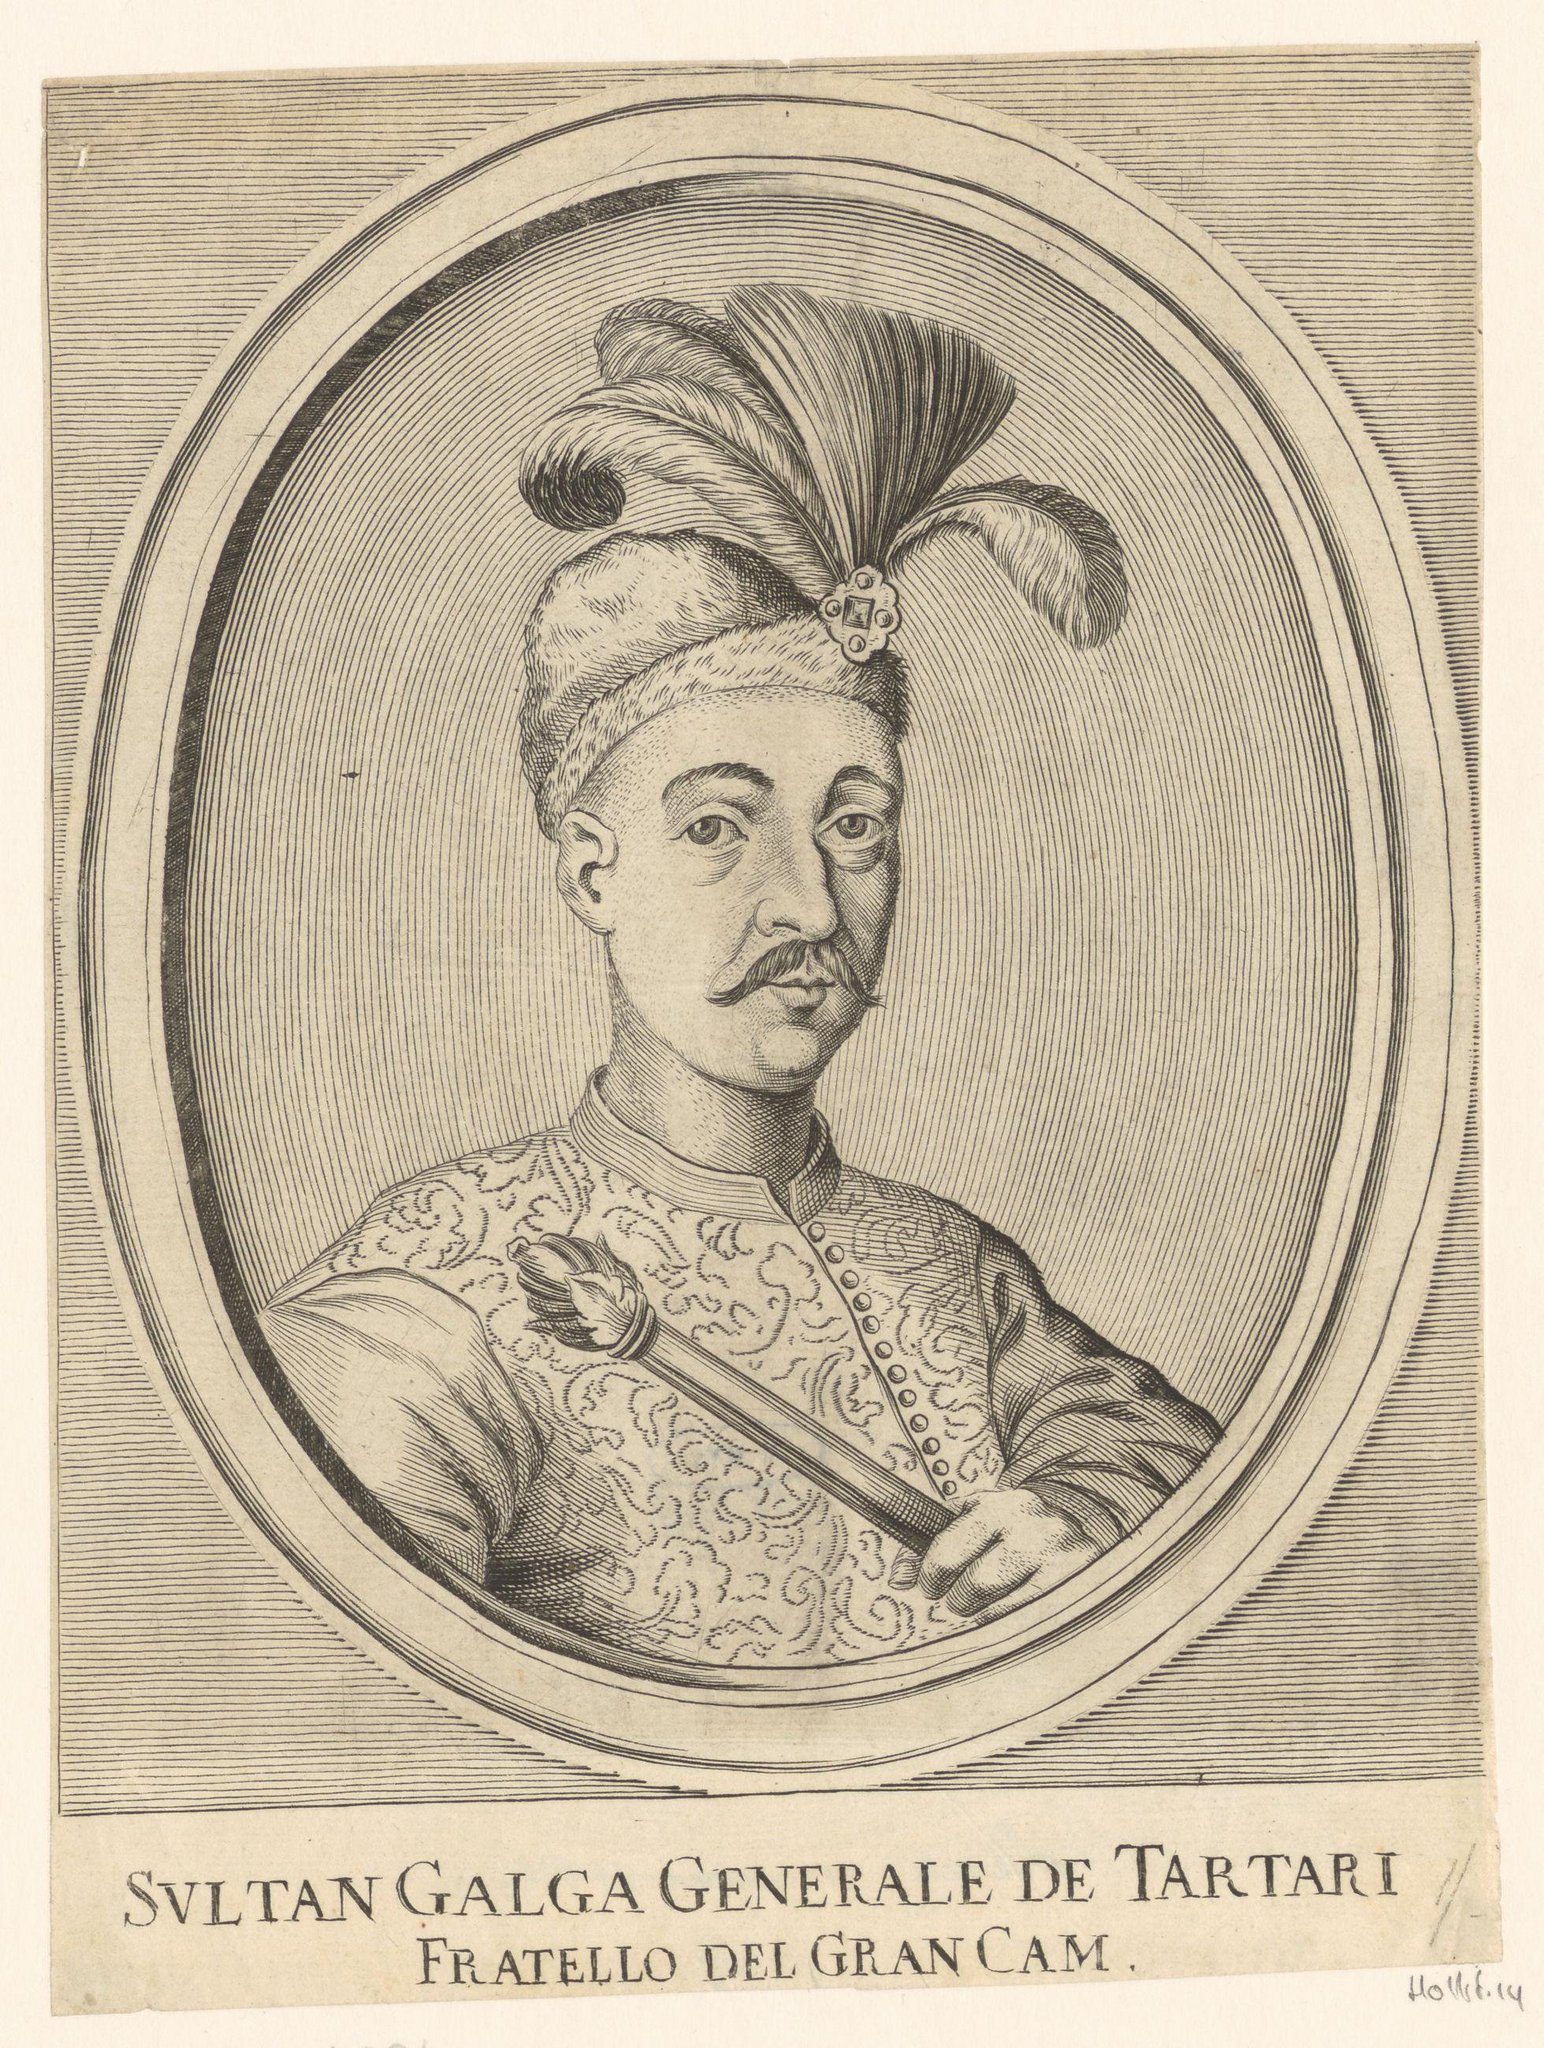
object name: print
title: Portret van Sultan Galga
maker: moritz lang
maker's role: draughtsman, print maker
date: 1649-1670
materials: paper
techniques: engraving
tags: historical persons, ruler, sovereign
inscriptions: collector's mark: Lugt 2228